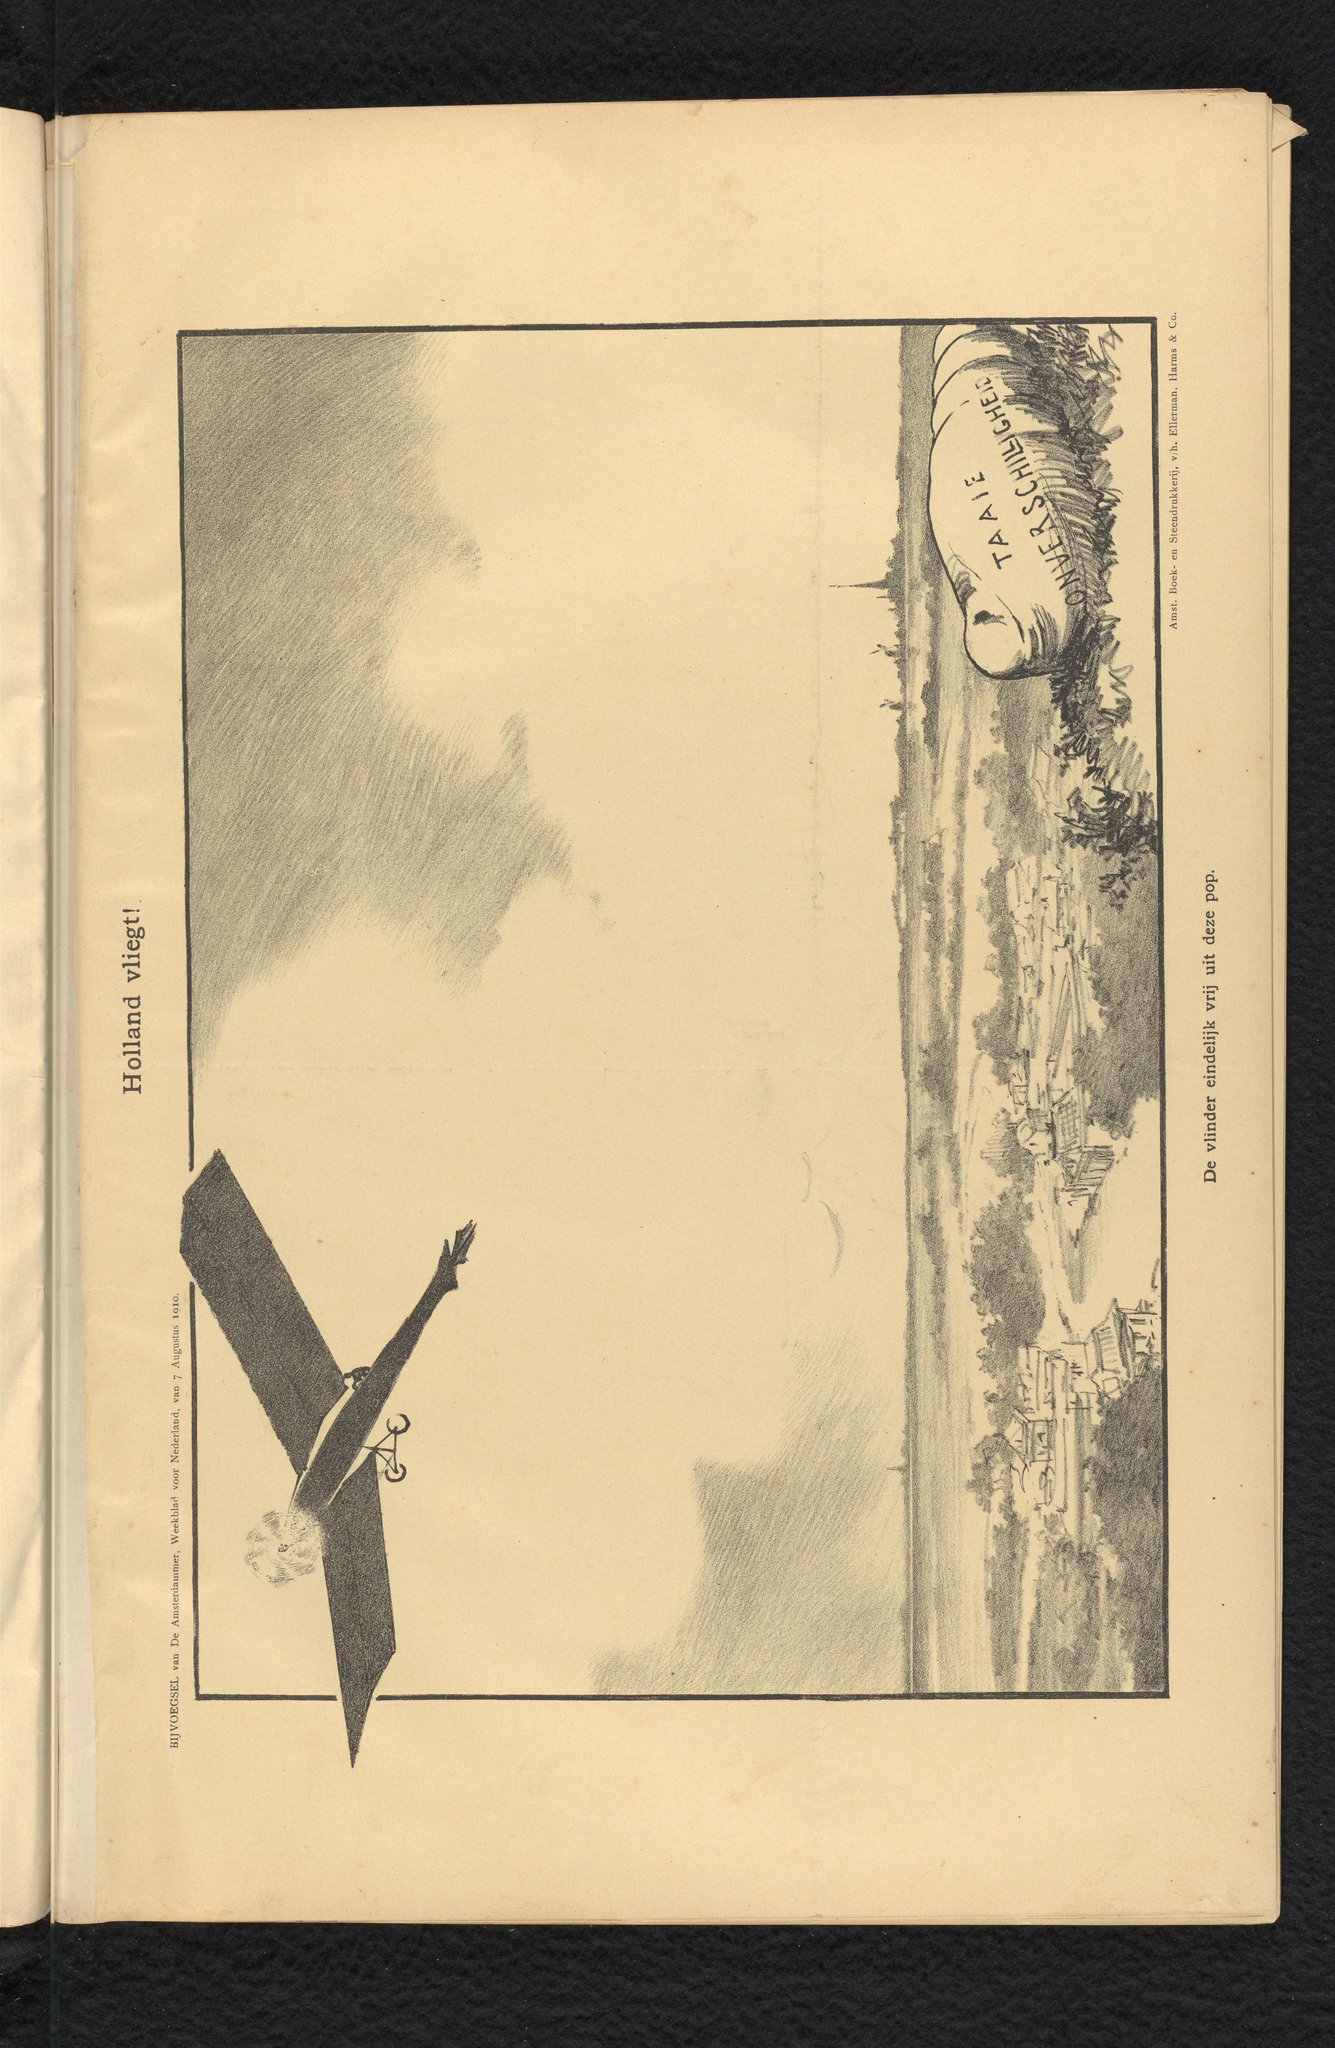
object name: cartoon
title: Holland vliegt!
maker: johan braakensiek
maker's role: draughtsman, print maker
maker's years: 1858-1940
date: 1910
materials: paper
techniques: lithograph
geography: netherlands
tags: aircraft, aeroplane, political caricatures and satires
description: Een Nederlands vliegtuig hoog boven het land, als een vlinder die eindelijk bevrijd is uit de pop van 'taaie onverschilligheid'.